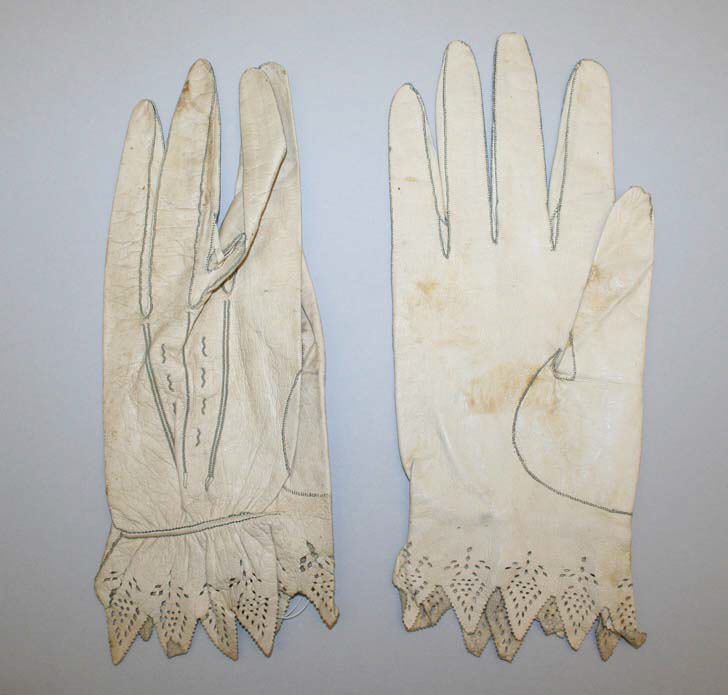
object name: glove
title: Gloves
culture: american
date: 1876-1900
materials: leather